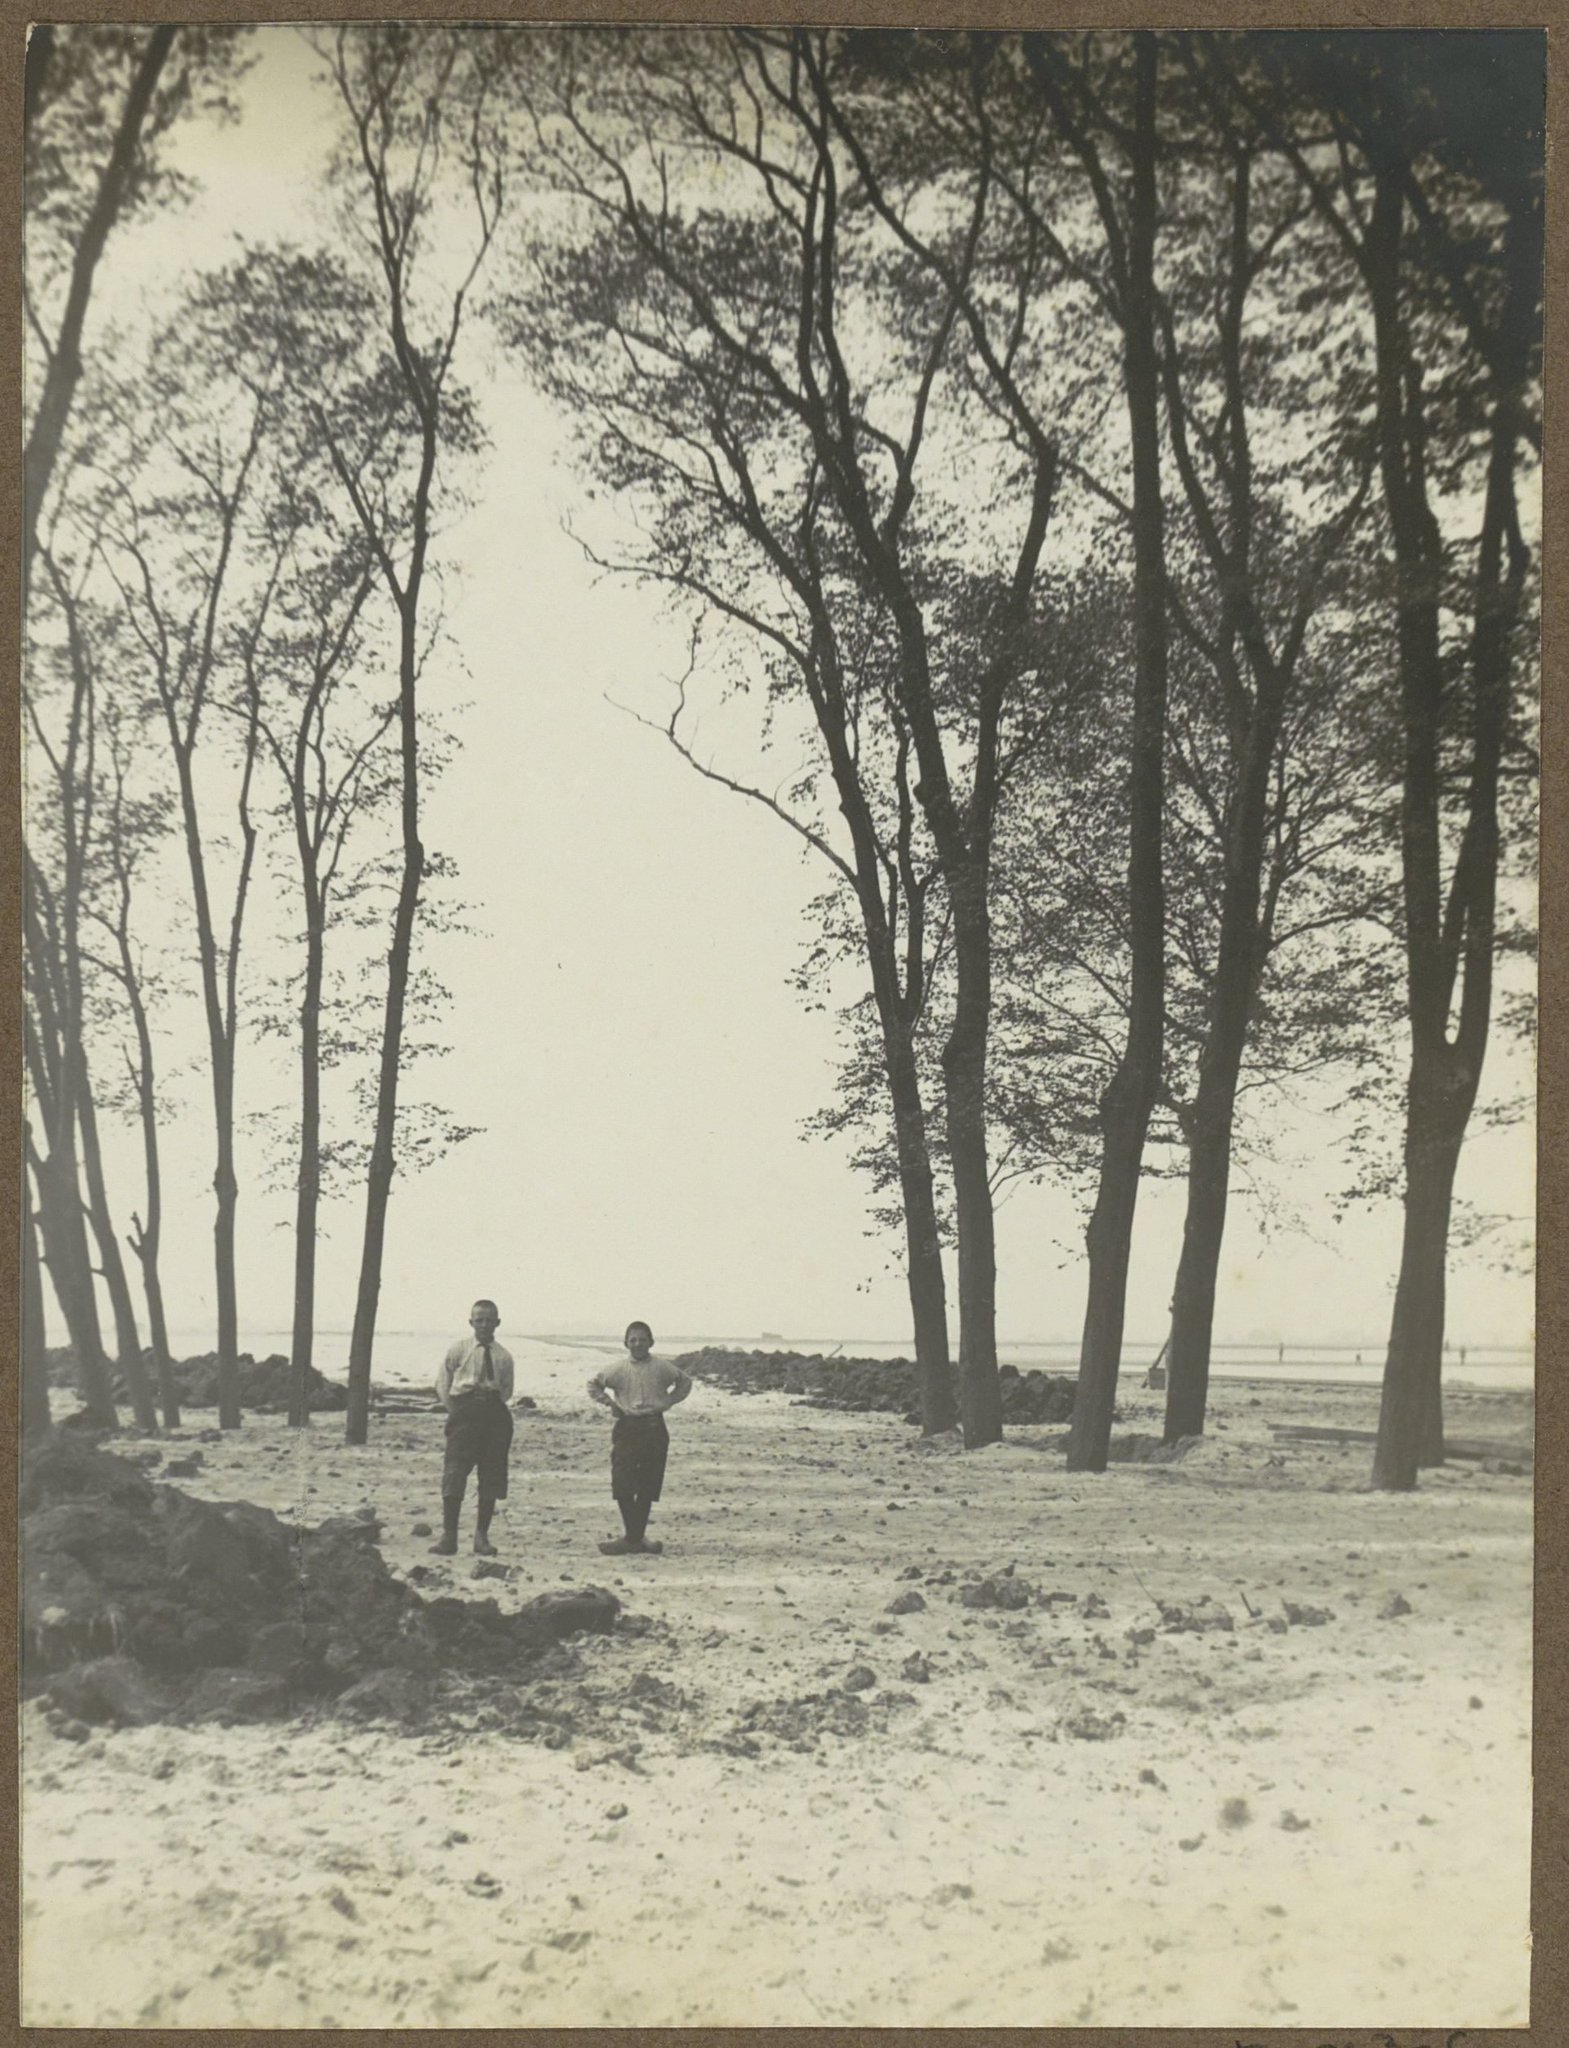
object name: photograph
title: Jongens onder bomen, vermoedelijk bij Uithoorn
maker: Anonymous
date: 1900-1915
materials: paper, photographic support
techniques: gelatin silver print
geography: uithoorn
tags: trees, child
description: Onderdeel van Album met foto's van Amsterdam en omgeving.